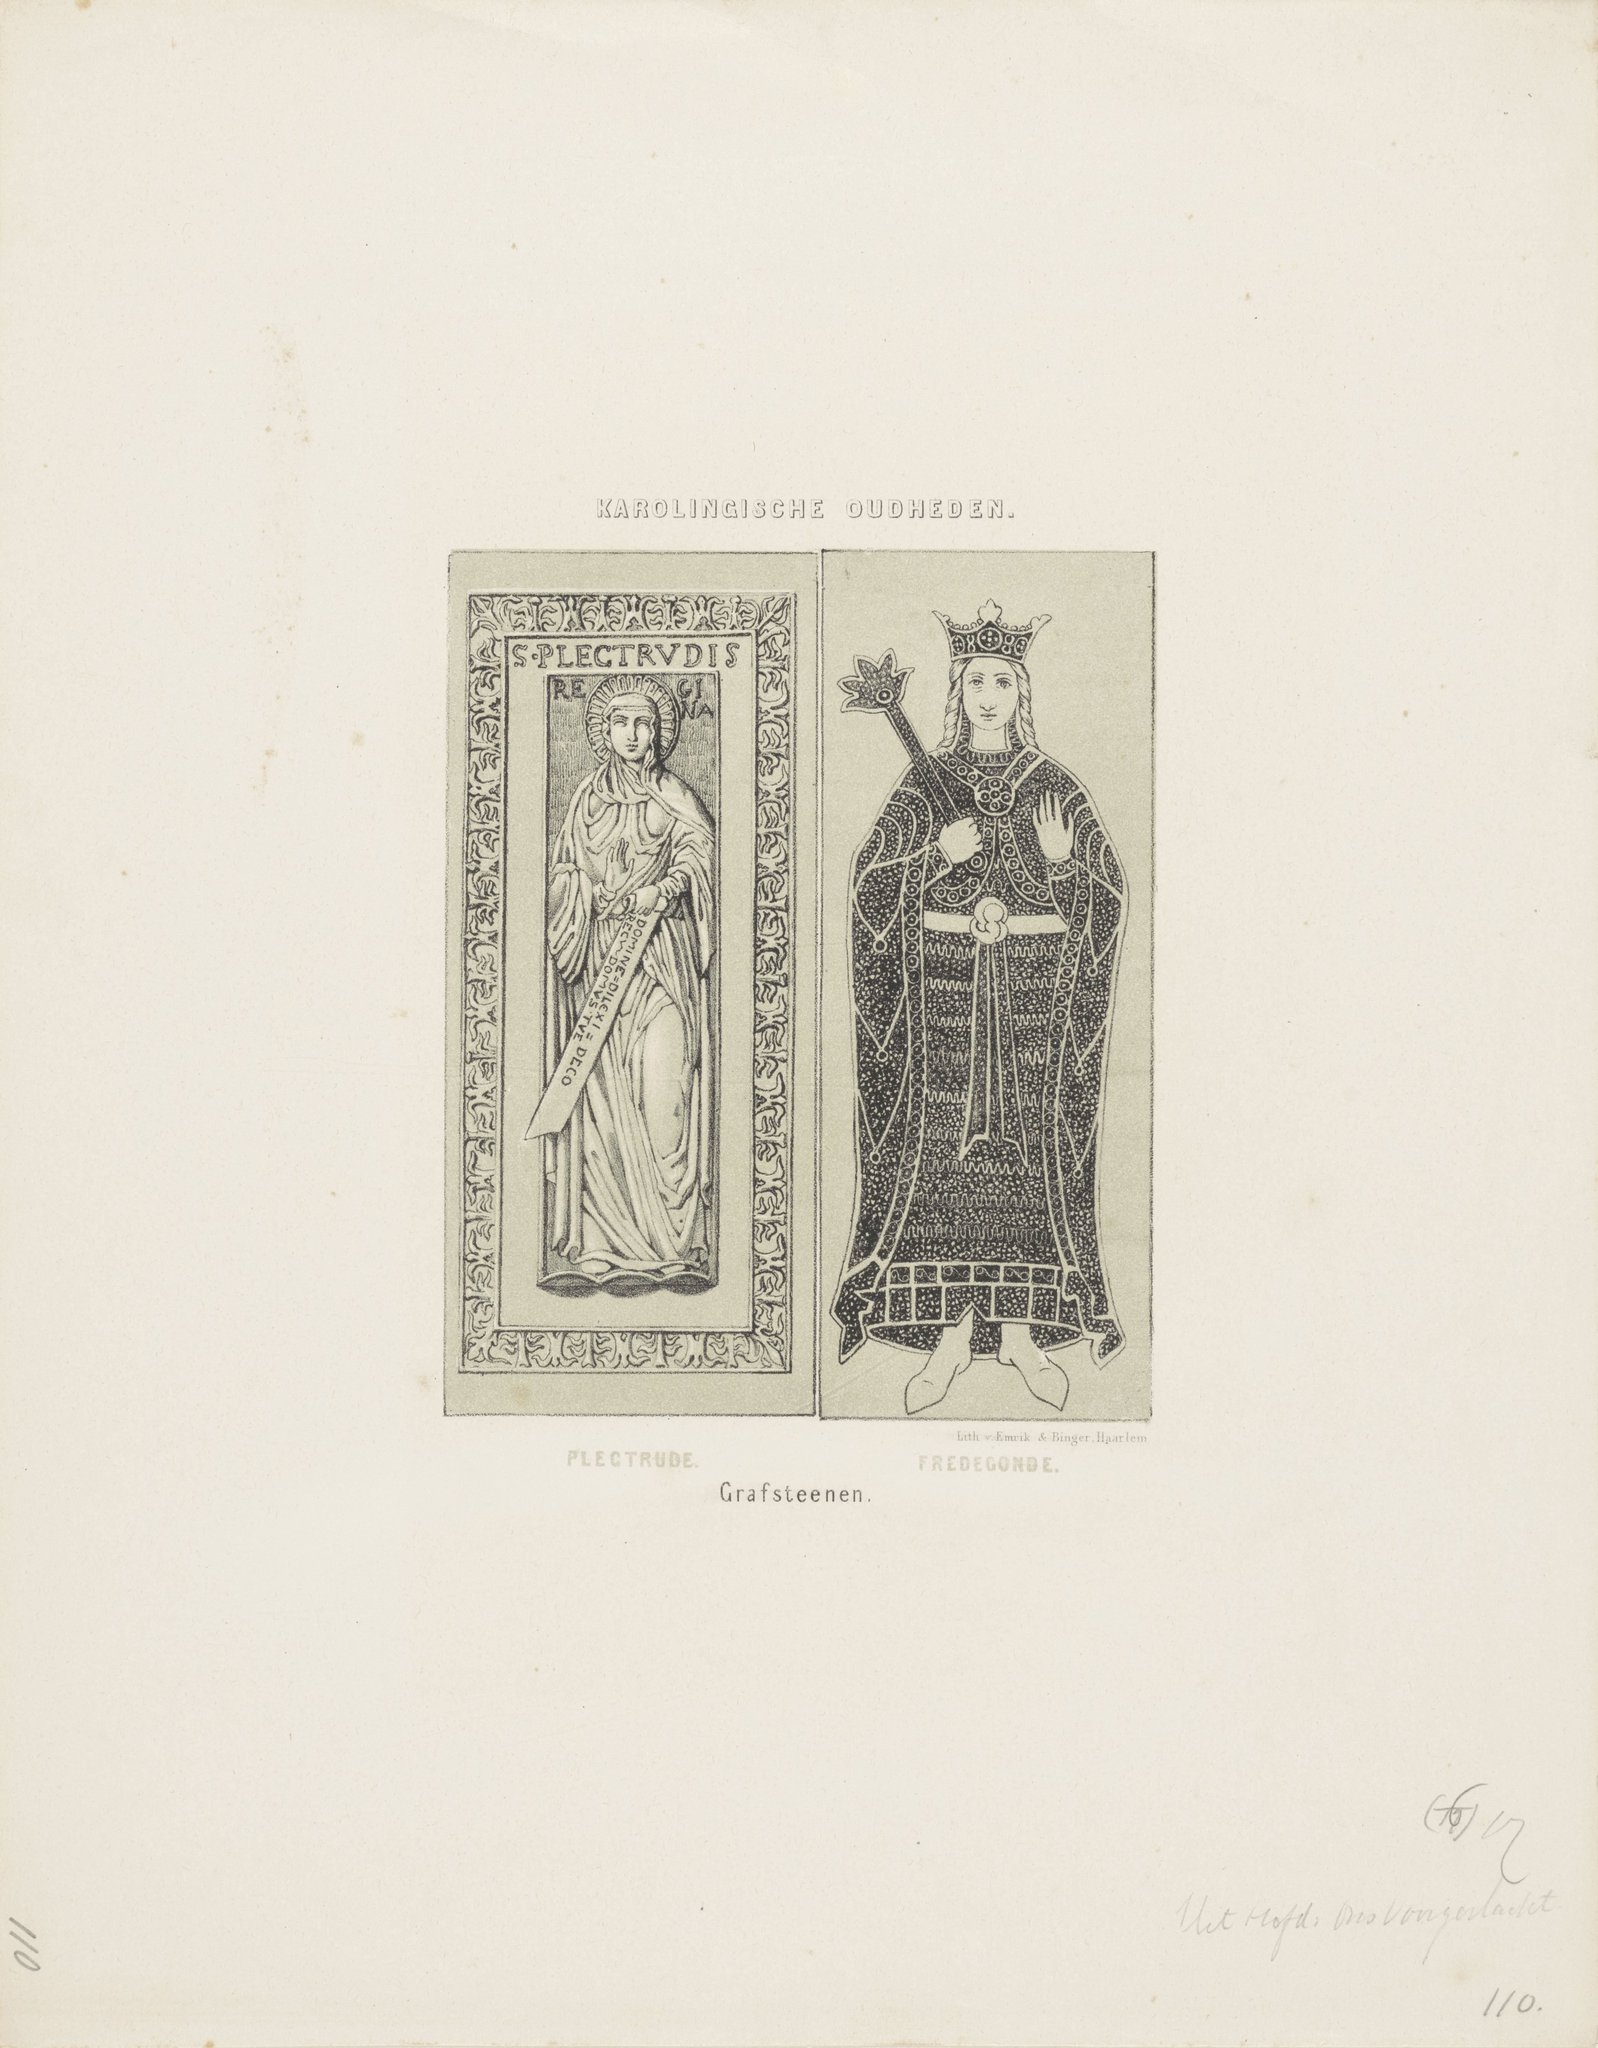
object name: print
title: Karolingische oudheden. Grafsteenen. Plectrude / Fredegonde.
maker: Anonymous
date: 1857-1864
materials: paper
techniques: tone lithography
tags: effigy, 'gisant' (portrait-figure on closed coffin or in 'castrum doloris'), transi, gravestone, tombstone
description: Illustratie voor: W.J. Hofdijk, Ons voorgeslacht in zijn dagelyksch leven geschilderd, Kruseman, Haarlem 1859-1864.